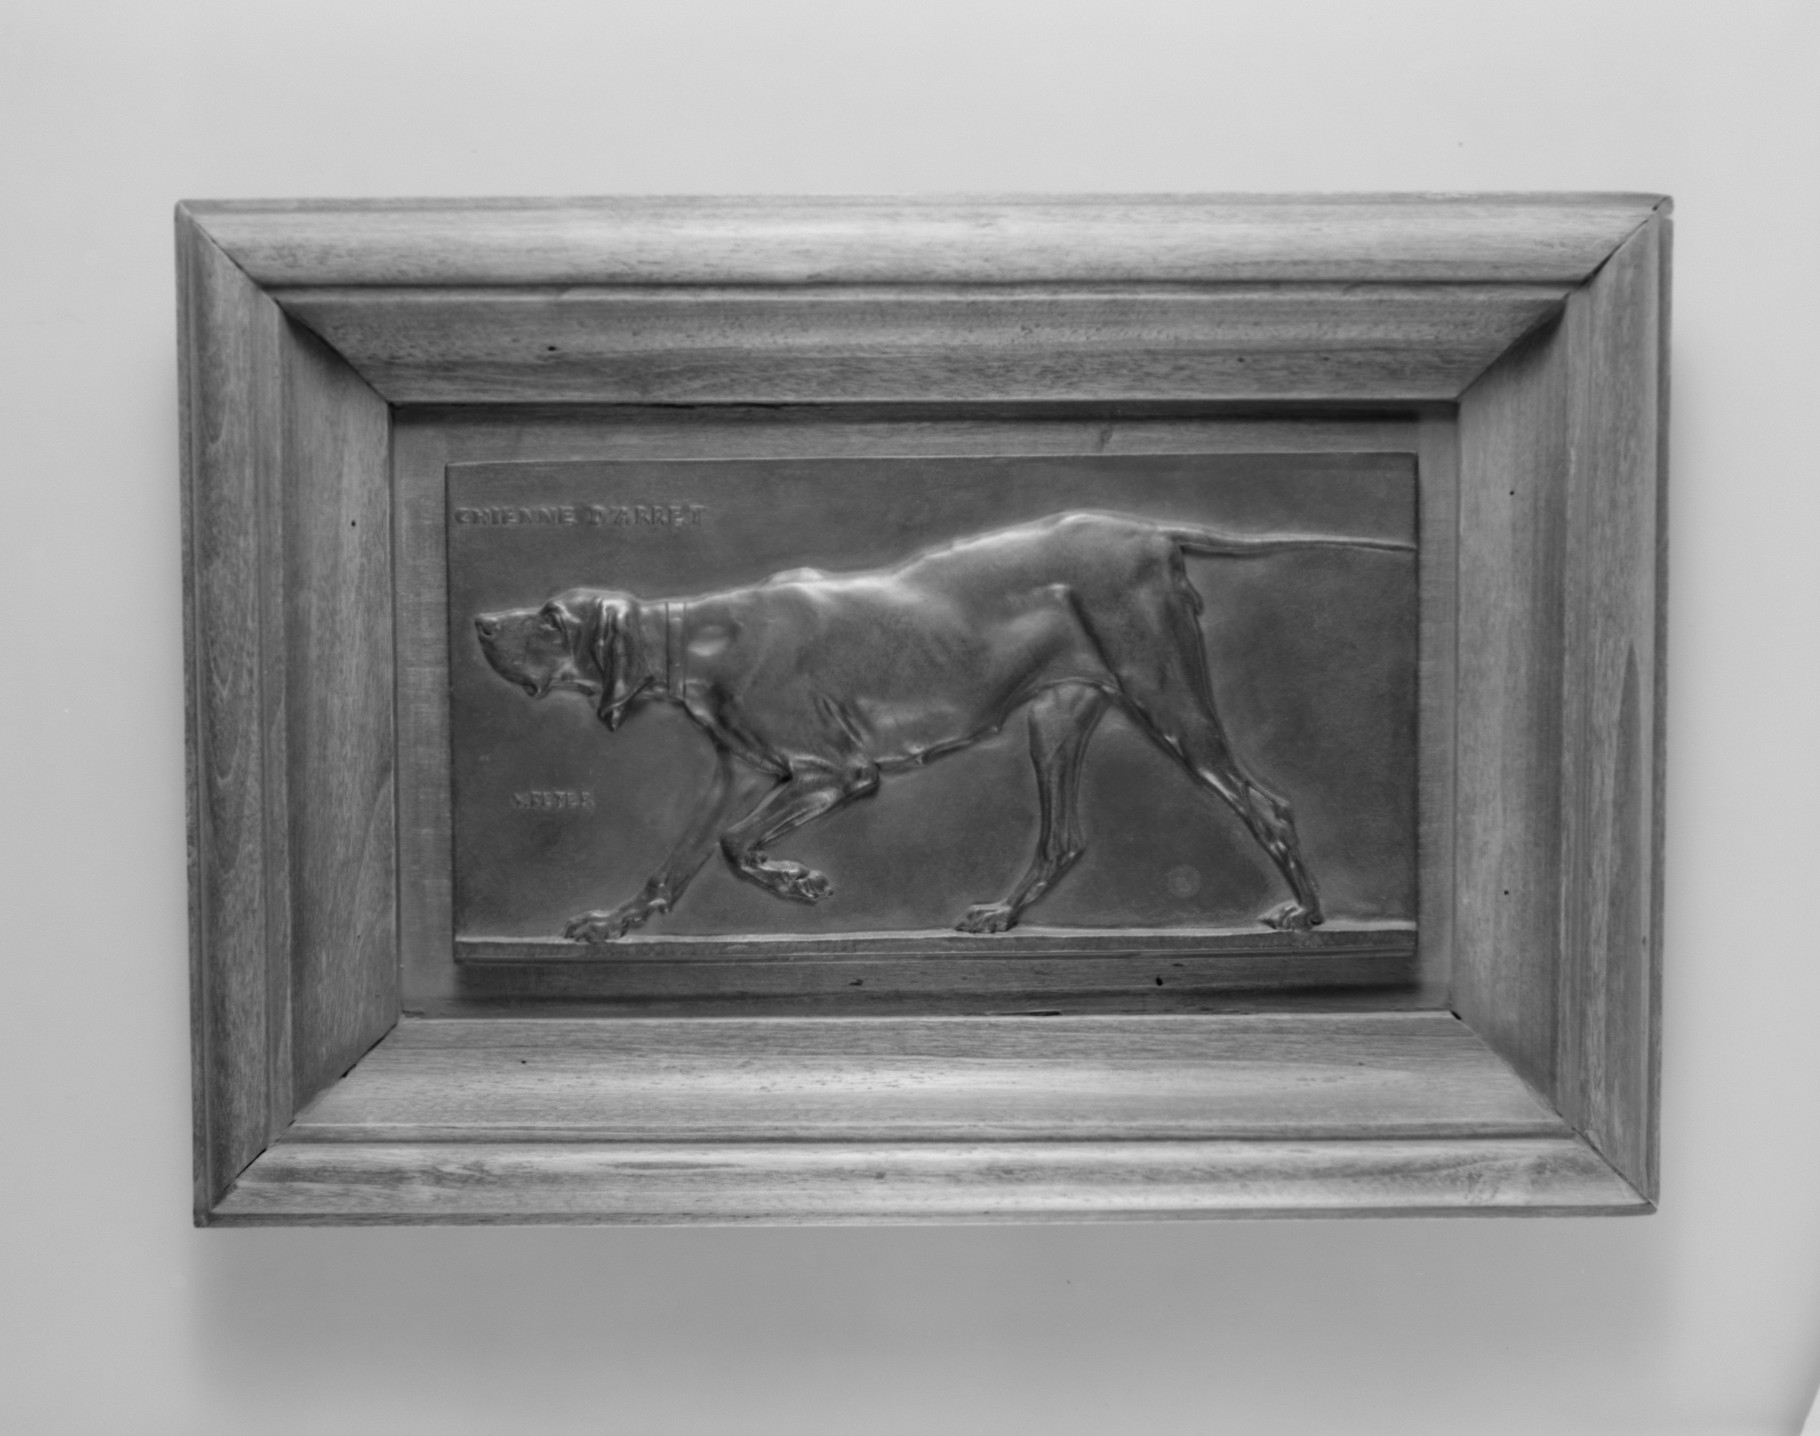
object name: plaque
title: A Pointer Bitch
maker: victor peter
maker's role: artist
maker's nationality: french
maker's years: 1840-1918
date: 1886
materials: bronze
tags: dogs